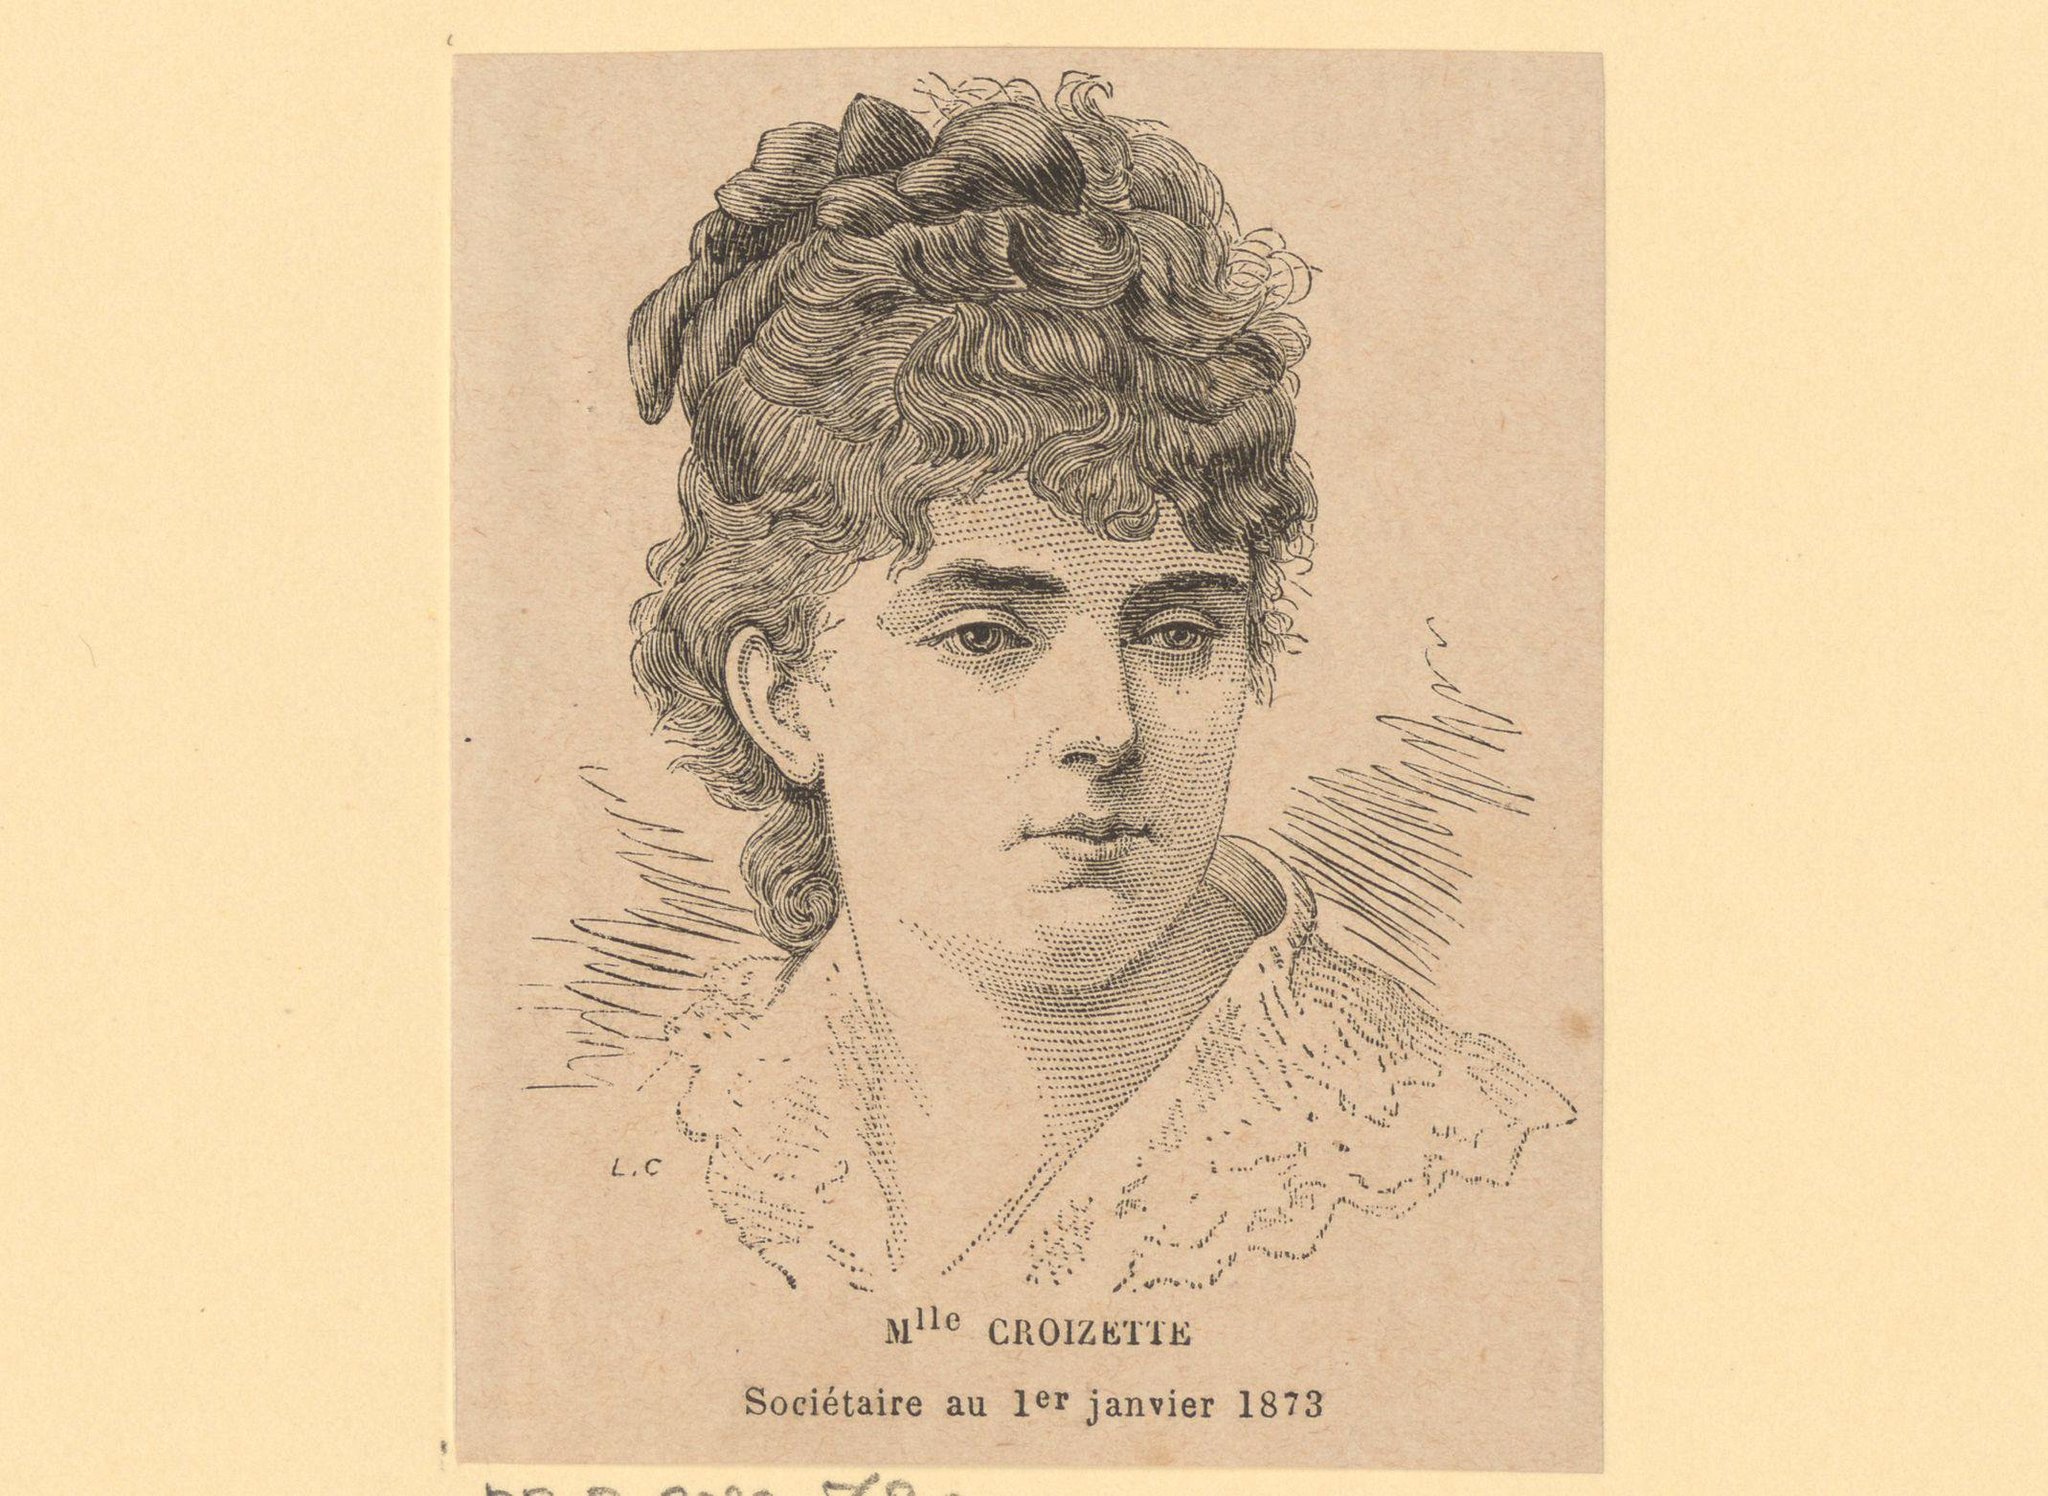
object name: print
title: Portret van Sophie Croizette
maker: léon-louis chapon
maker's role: print maker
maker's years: 1836-1918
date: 1887-1889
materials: paper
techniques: engraving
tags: historical persons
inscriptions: : Lugt 2228